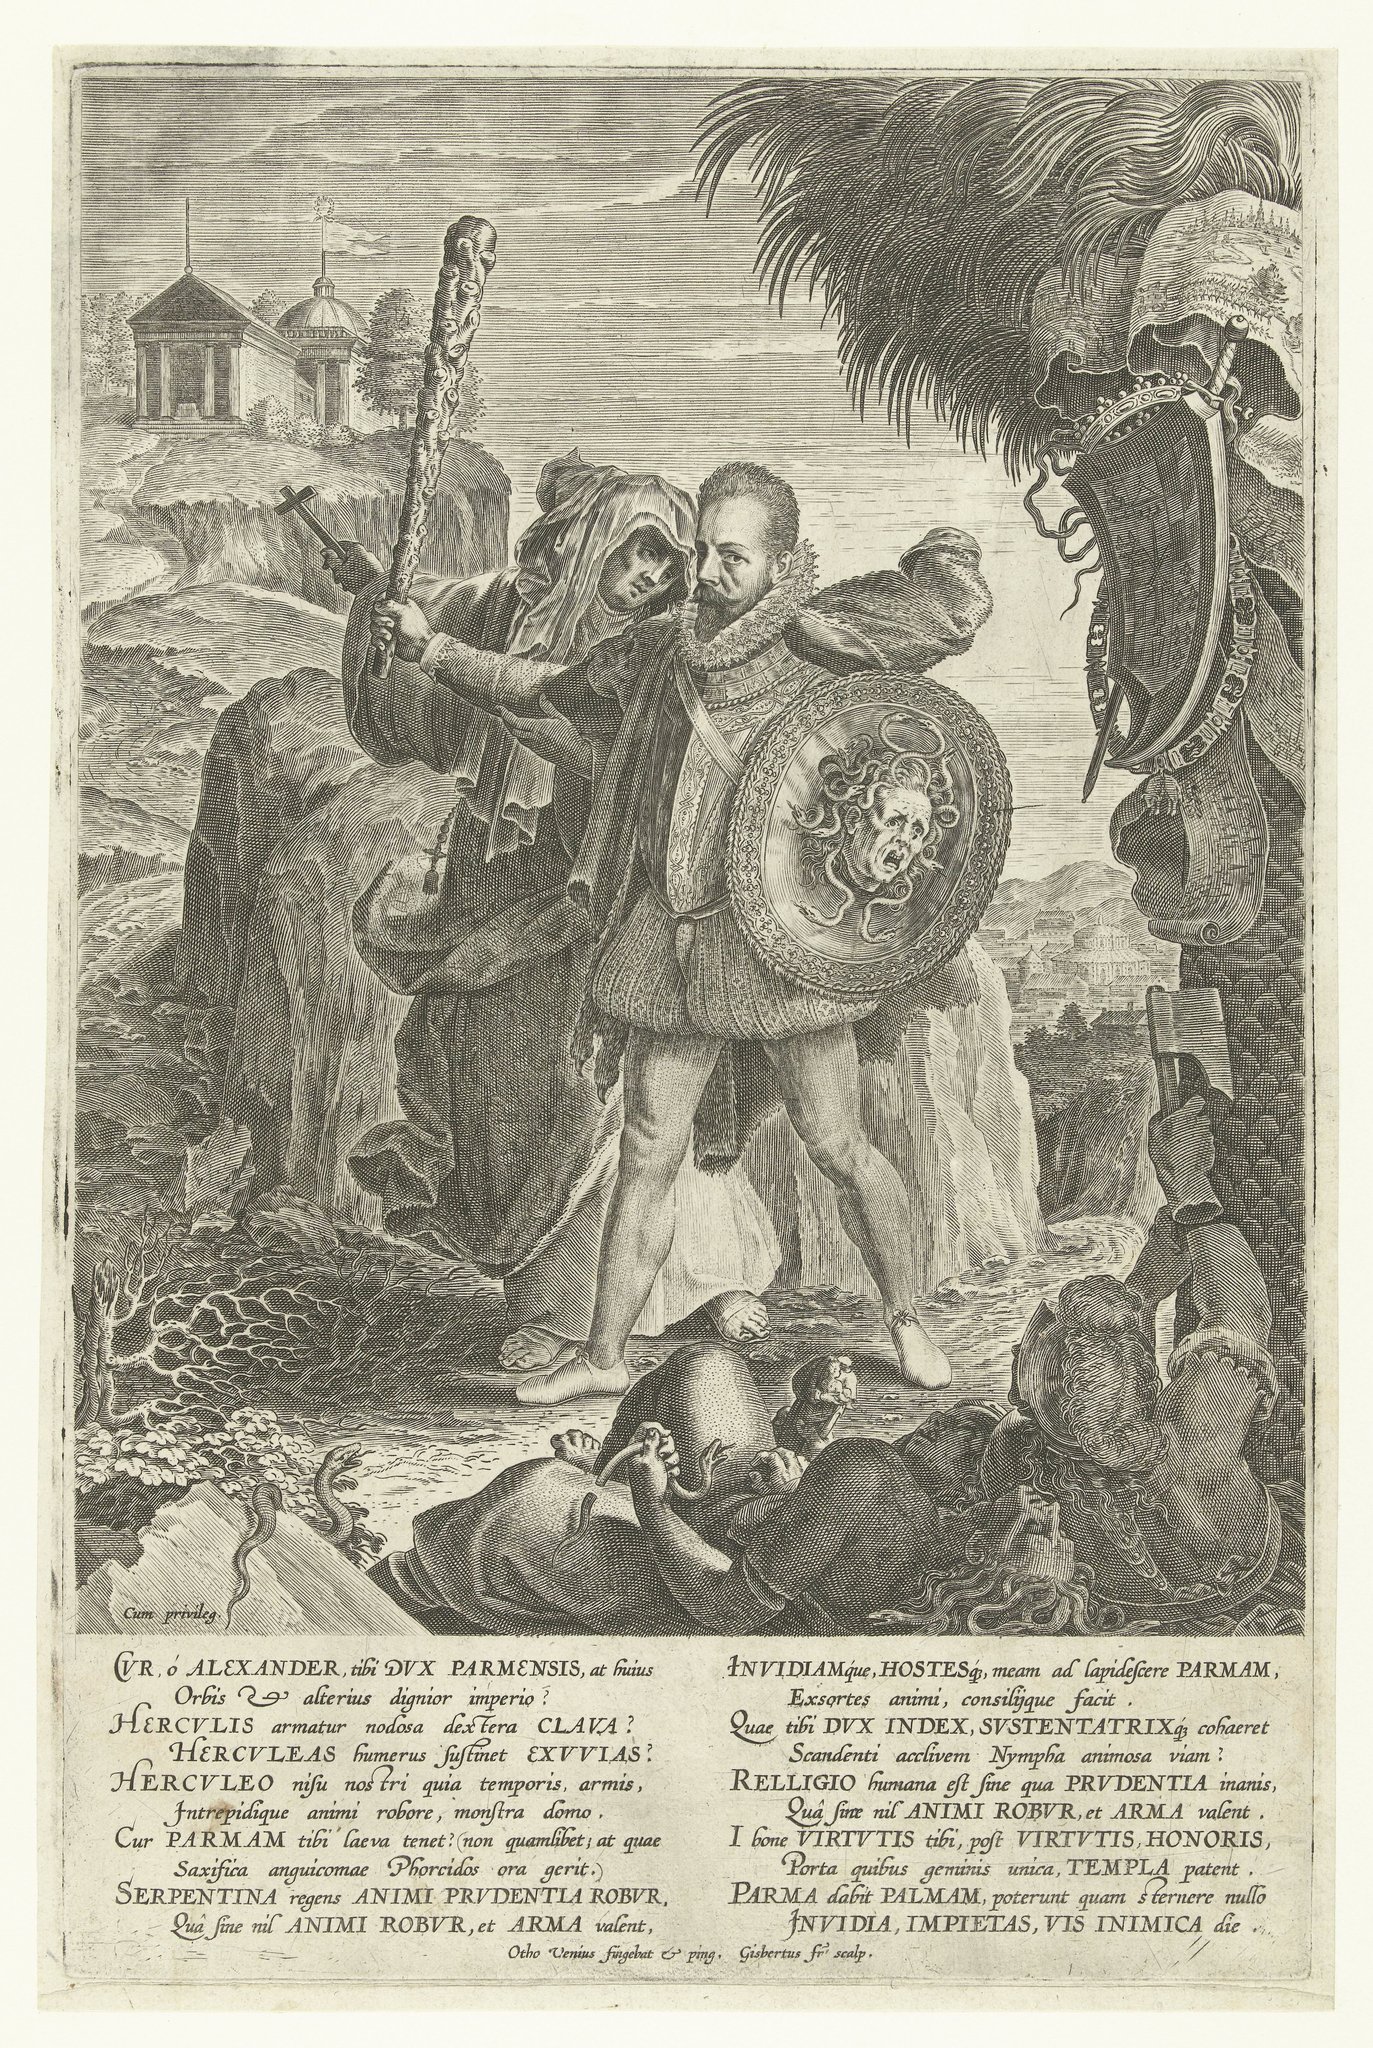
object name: print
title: Allegorie met de hertog van Parma als voorvechter van de katholieke kerk in de Nederlanden, 1585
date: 1585-1592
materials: paper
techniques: engraving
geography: southern netherlands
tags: rome, alessandro farnese (landvoogd van de nederlanden en hertog van parma en piacenza), impiety; 'impietà' (ripa), envy; 'invidia' (ripa) ~ personification of one of the seven deadly sins, the church personified, 'ecclesia', usually with chalice and banner, specific aspects, allegorical aspects of hercules; hercules as patron, beeldenstorm (1566)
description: Allegorie met Alexander Farnese, de hertog van Parma, als voorvechter van de katholieke kerk in de Nederlanden, 1585. Parma als Hercules met knots en schild wordt door de personificatie van (Katholieke) Godsdienst naar de tempel van de deugd op een rots gewezen. Voor hem liggen verslagen op de grond Afgunst (Invidia), Onvroomheid (Impietas) met een kapot heiligenbeeld en Vijandige Kracht (Vis Inimica). Aan de palmboom rechts hangen het wapen van Parma en afbeeldingen van het beleg van Antwerpen en de schipbrug in 1585. Met onderschrift van 2 kolommen van 10 regels in het Latijn.